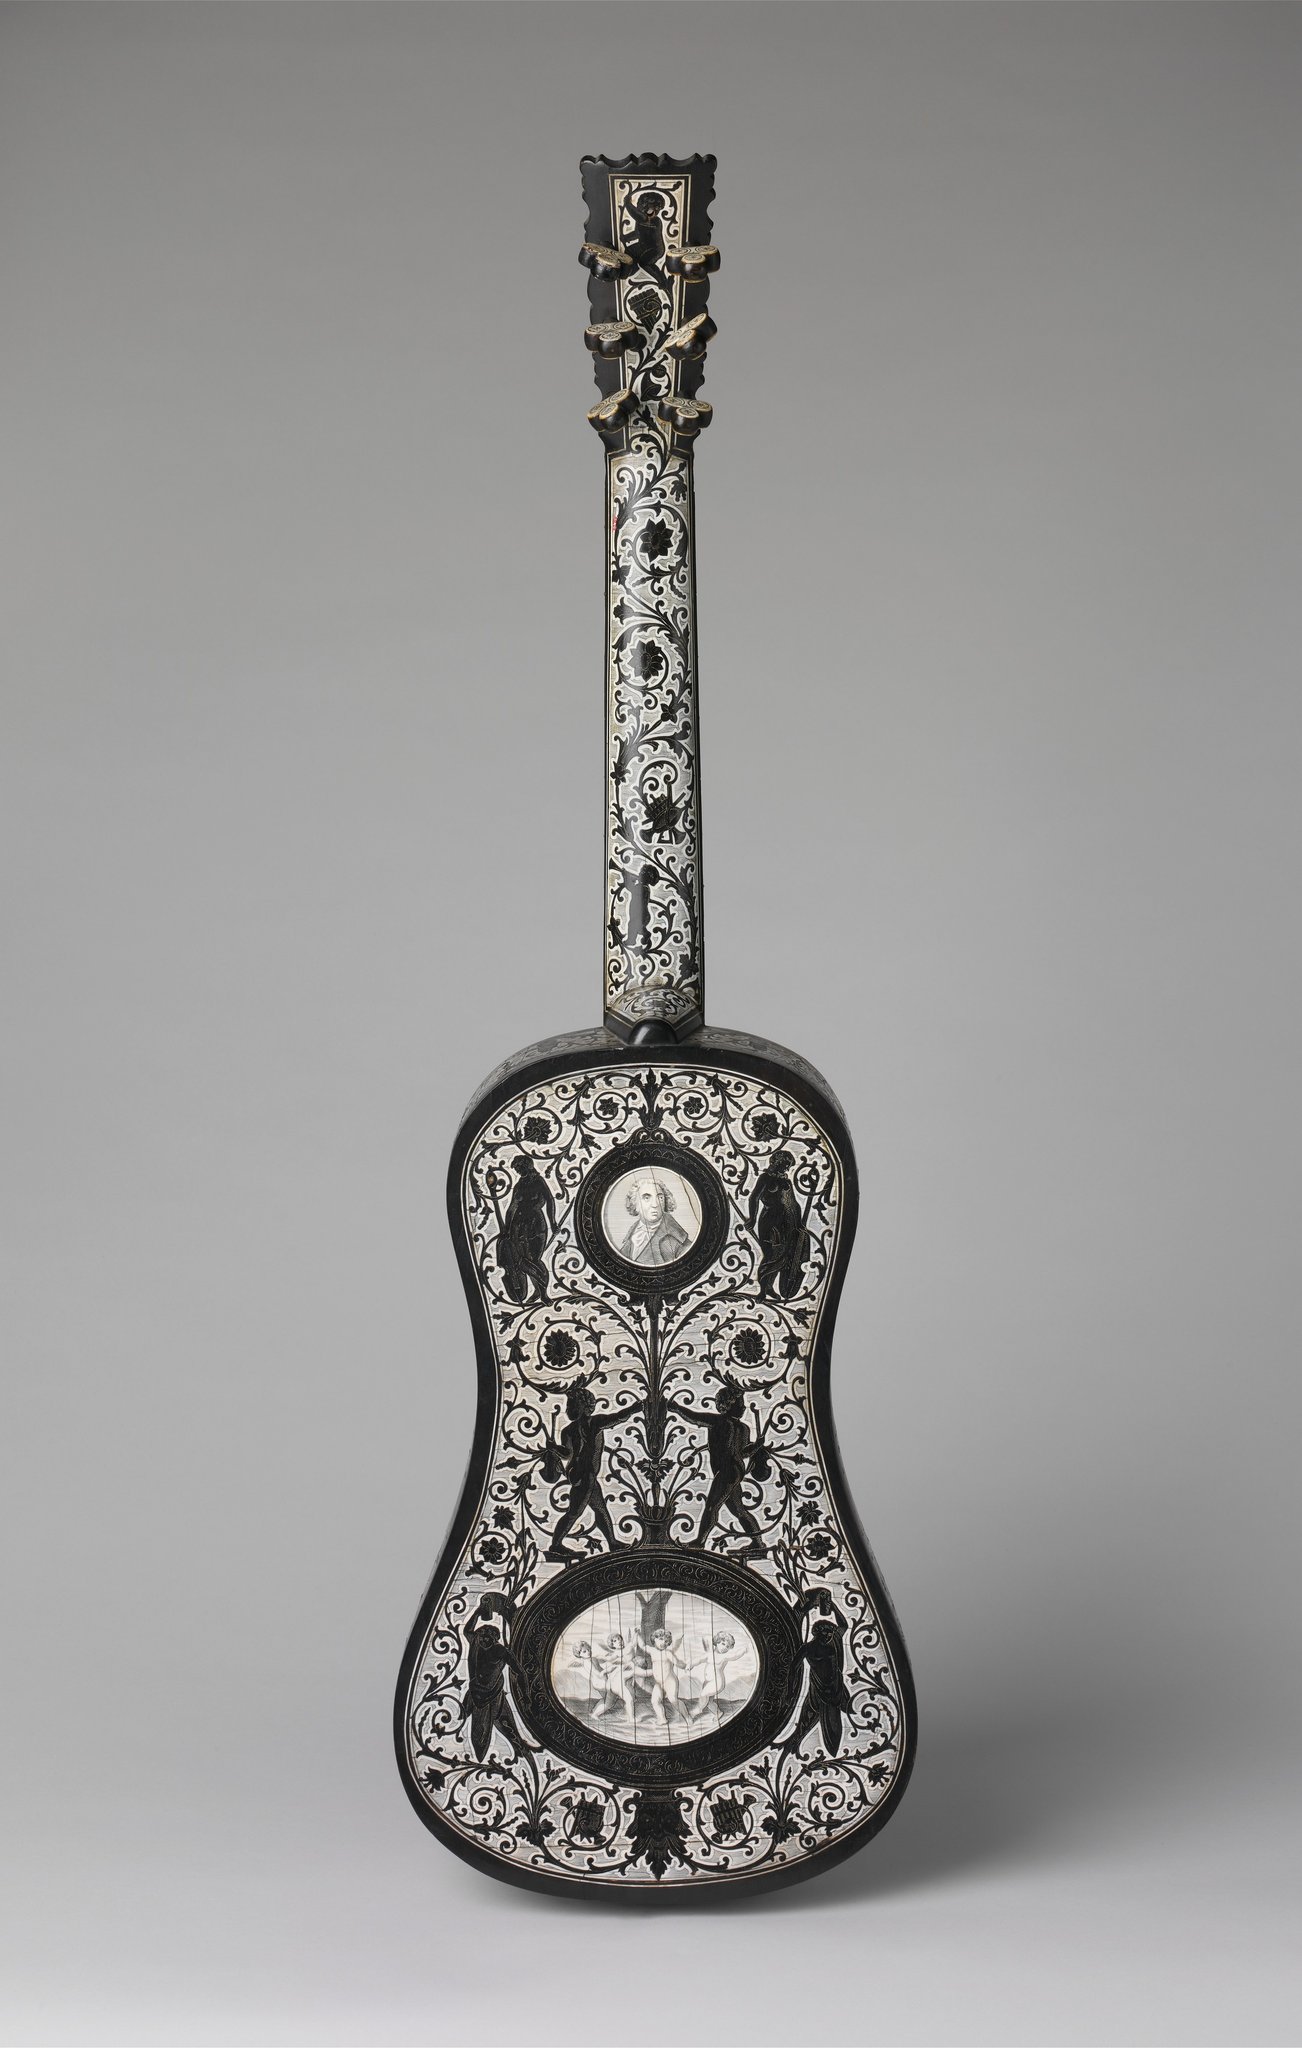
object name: guitar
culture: italian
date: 1800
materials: brass, wood, ivory, mother of pearl, shell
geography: italy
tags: men,putti